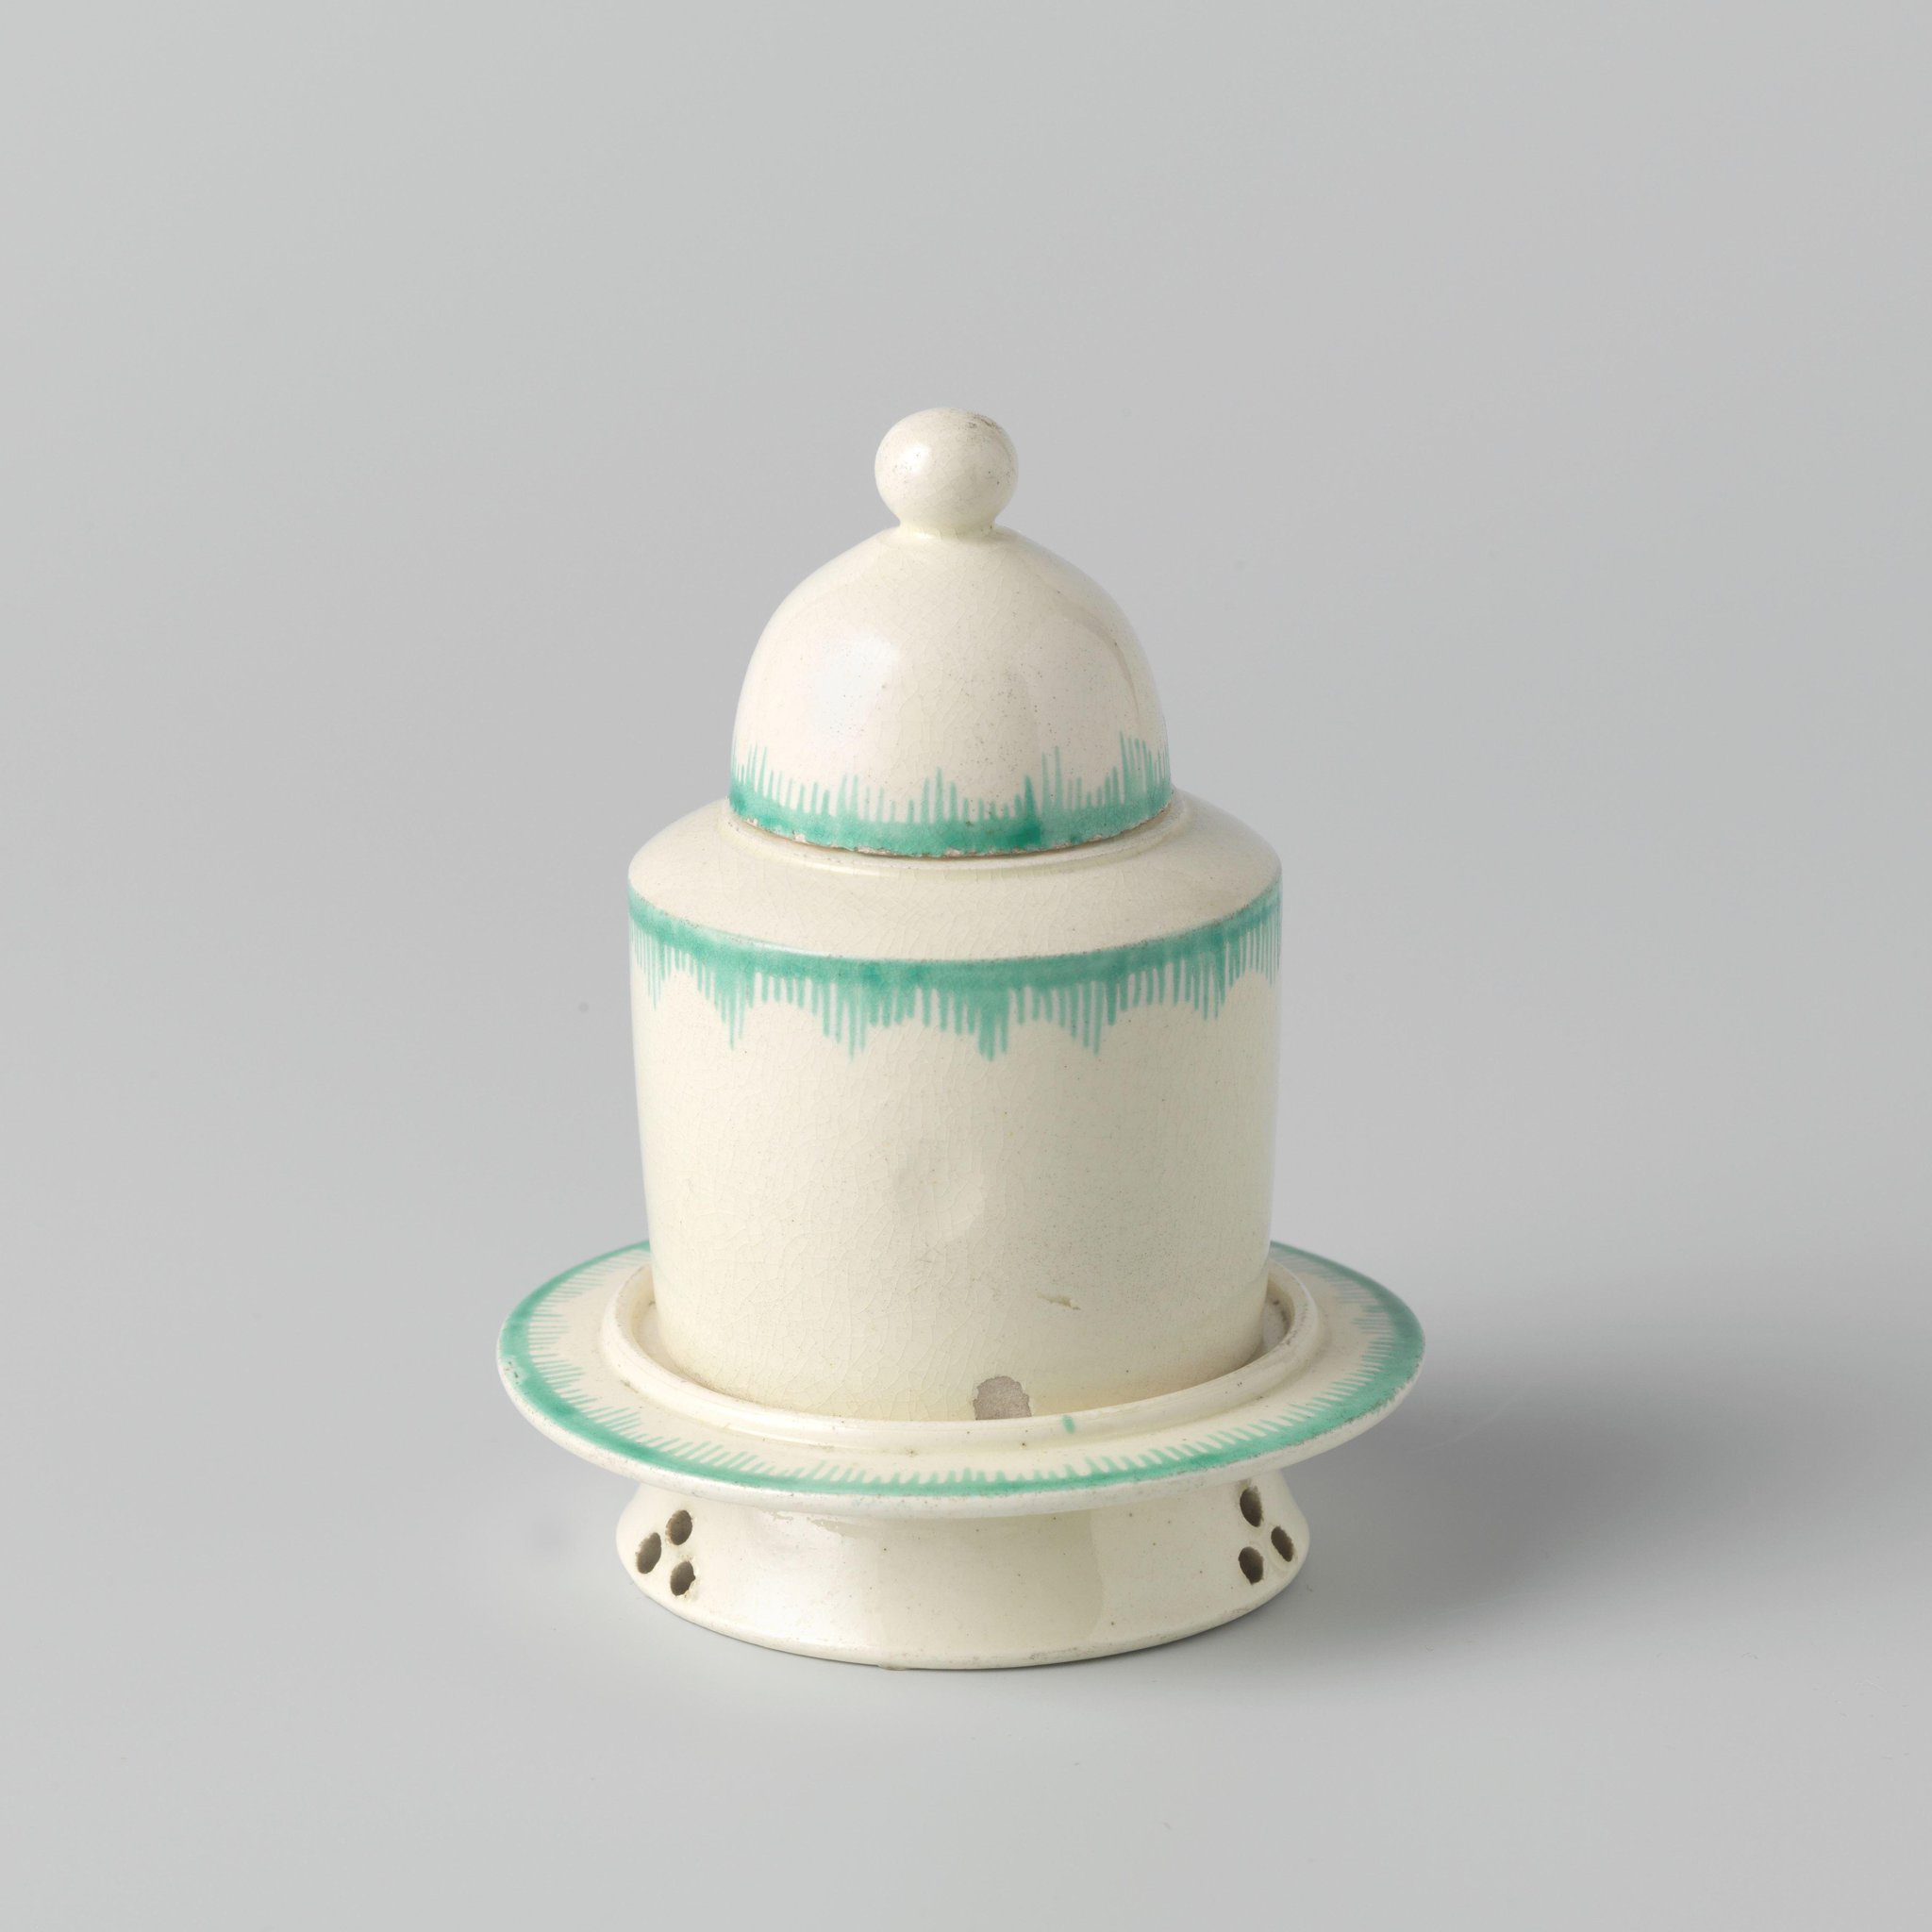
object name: tea caddy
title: Deksel van hardgebakken aardewerk, creamware.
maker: Anonymous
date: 1790-1810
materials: earthenware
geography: england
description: Het deksel is gewelfd en heeft een bolvorvormige knop. De dekselrand is versierd met een groen uitstralende rand.